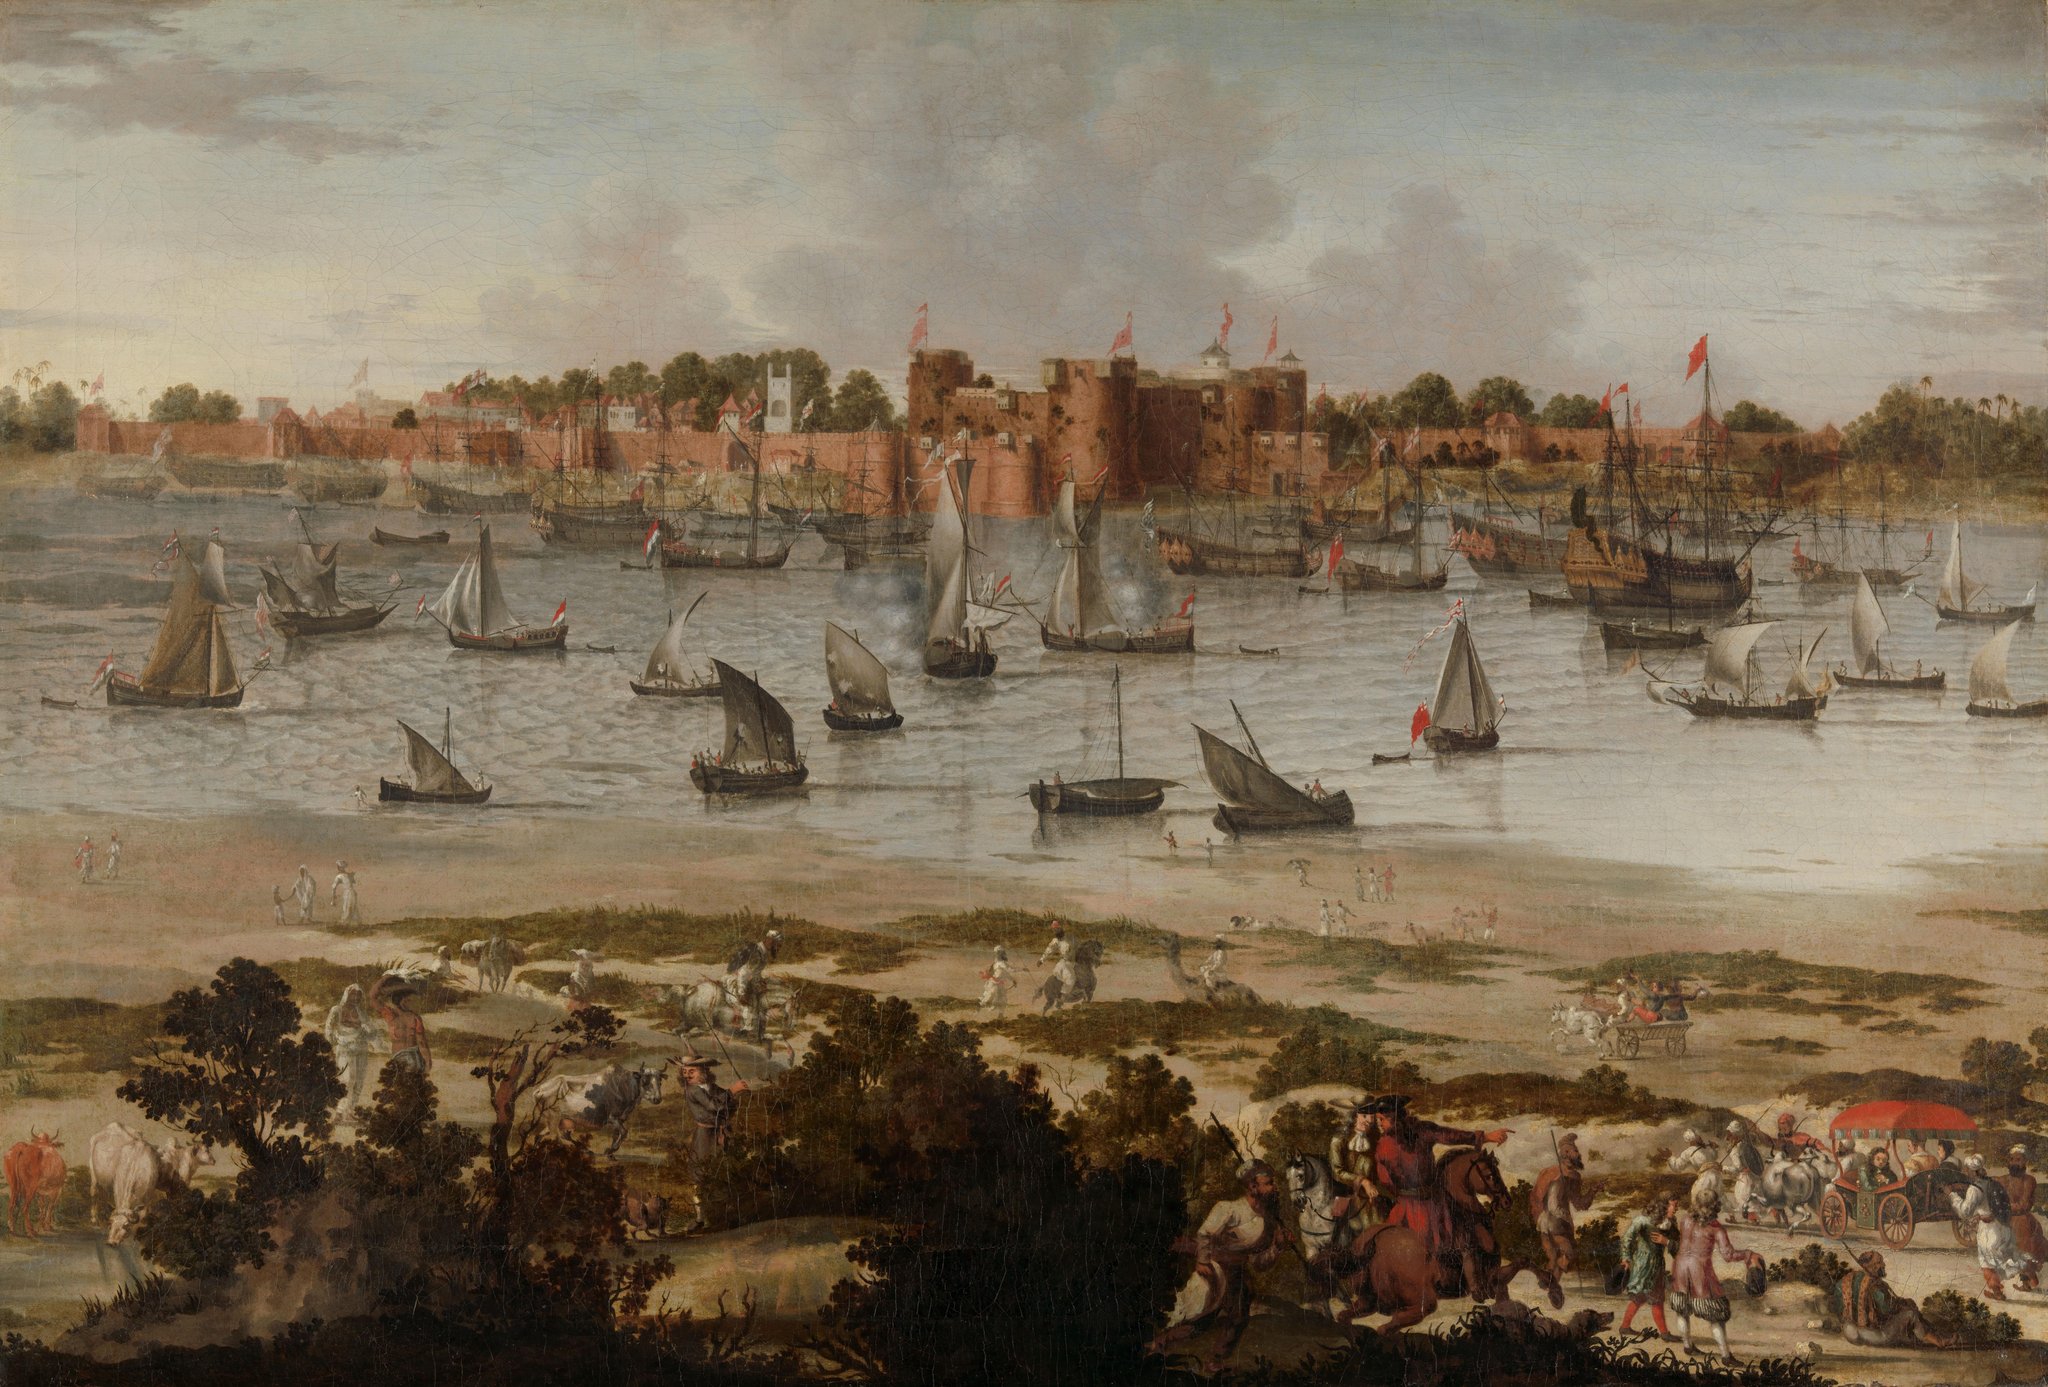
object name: painting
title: View of the Harbor of Sūrat (Gujarāt)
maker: Anonymous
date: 1670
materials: canvas, oil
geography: netherlands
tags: prospect of city, town panorama, silhouette of city - ii - ideal city, factory-building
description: View of Suratte, India. Anonymous, second half 17th century. For the VOC, the city of Suratte in northwest India was an important centre for the purchase of cotton fabrics to Suratte. The VOC brought spices, porcelain, Italian cloth and all kinds of curiosities for one of the principal Indian rulers, the Mughal emperor.